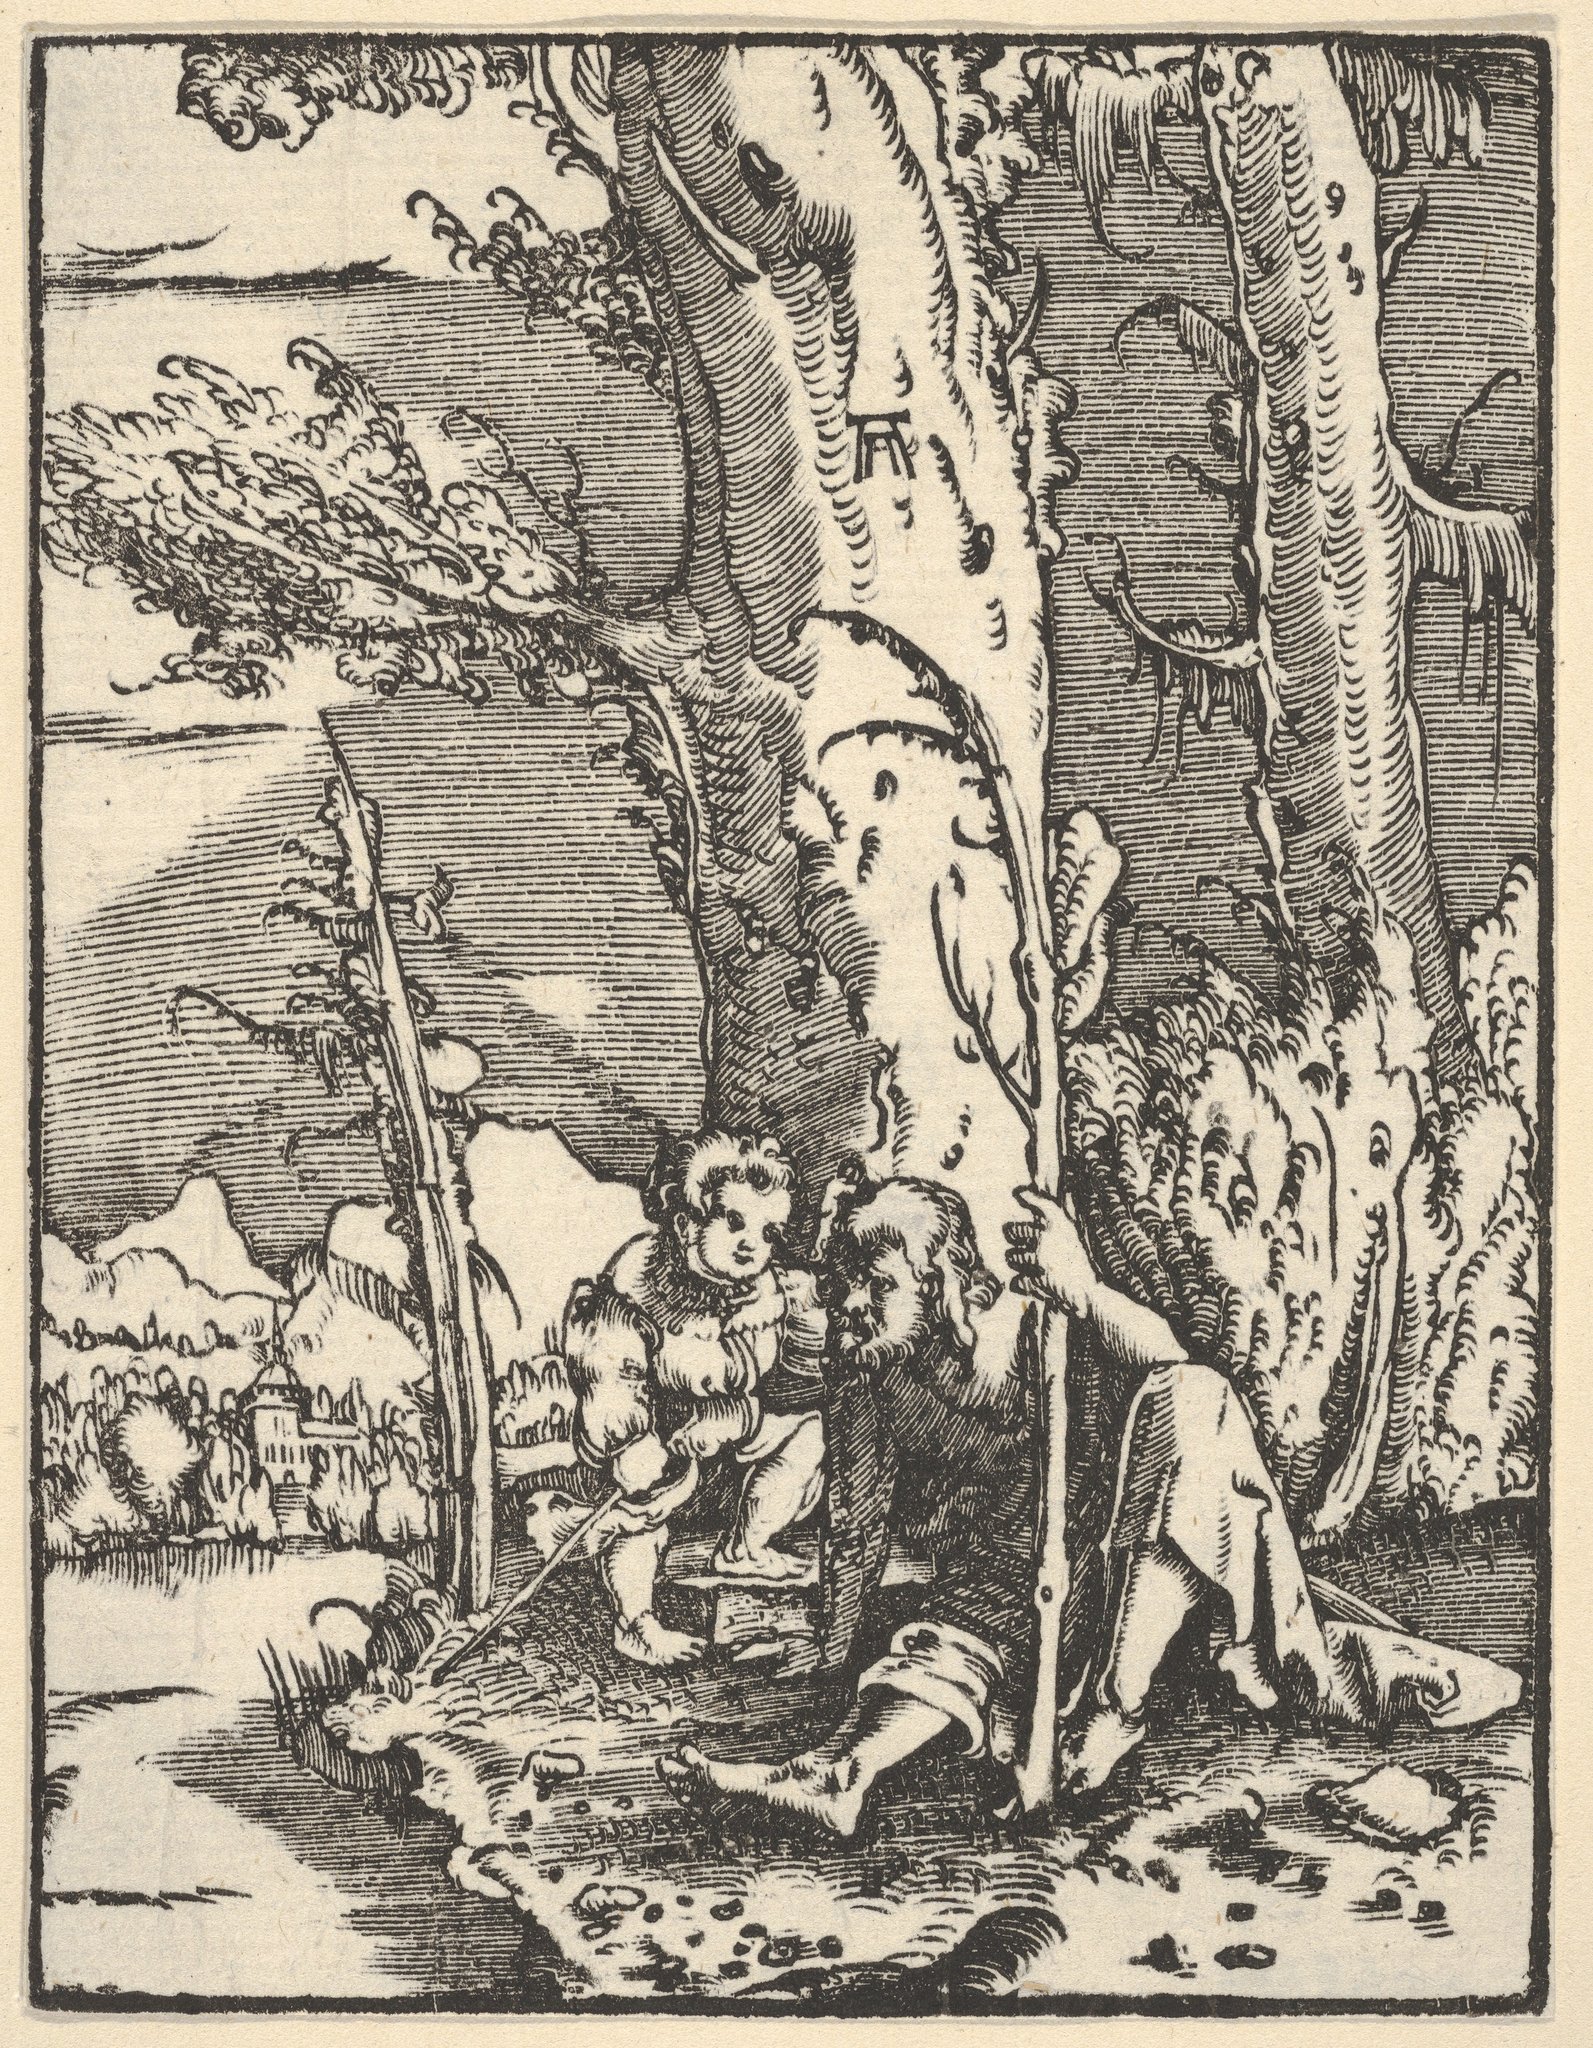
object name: print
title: Saint Christopher Seated with the Infant Christ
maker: albrecht altdorfer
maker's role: artist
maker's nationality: german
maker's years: 1480-1538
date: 1500-1538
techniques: woodcut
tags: christ,saint christopher